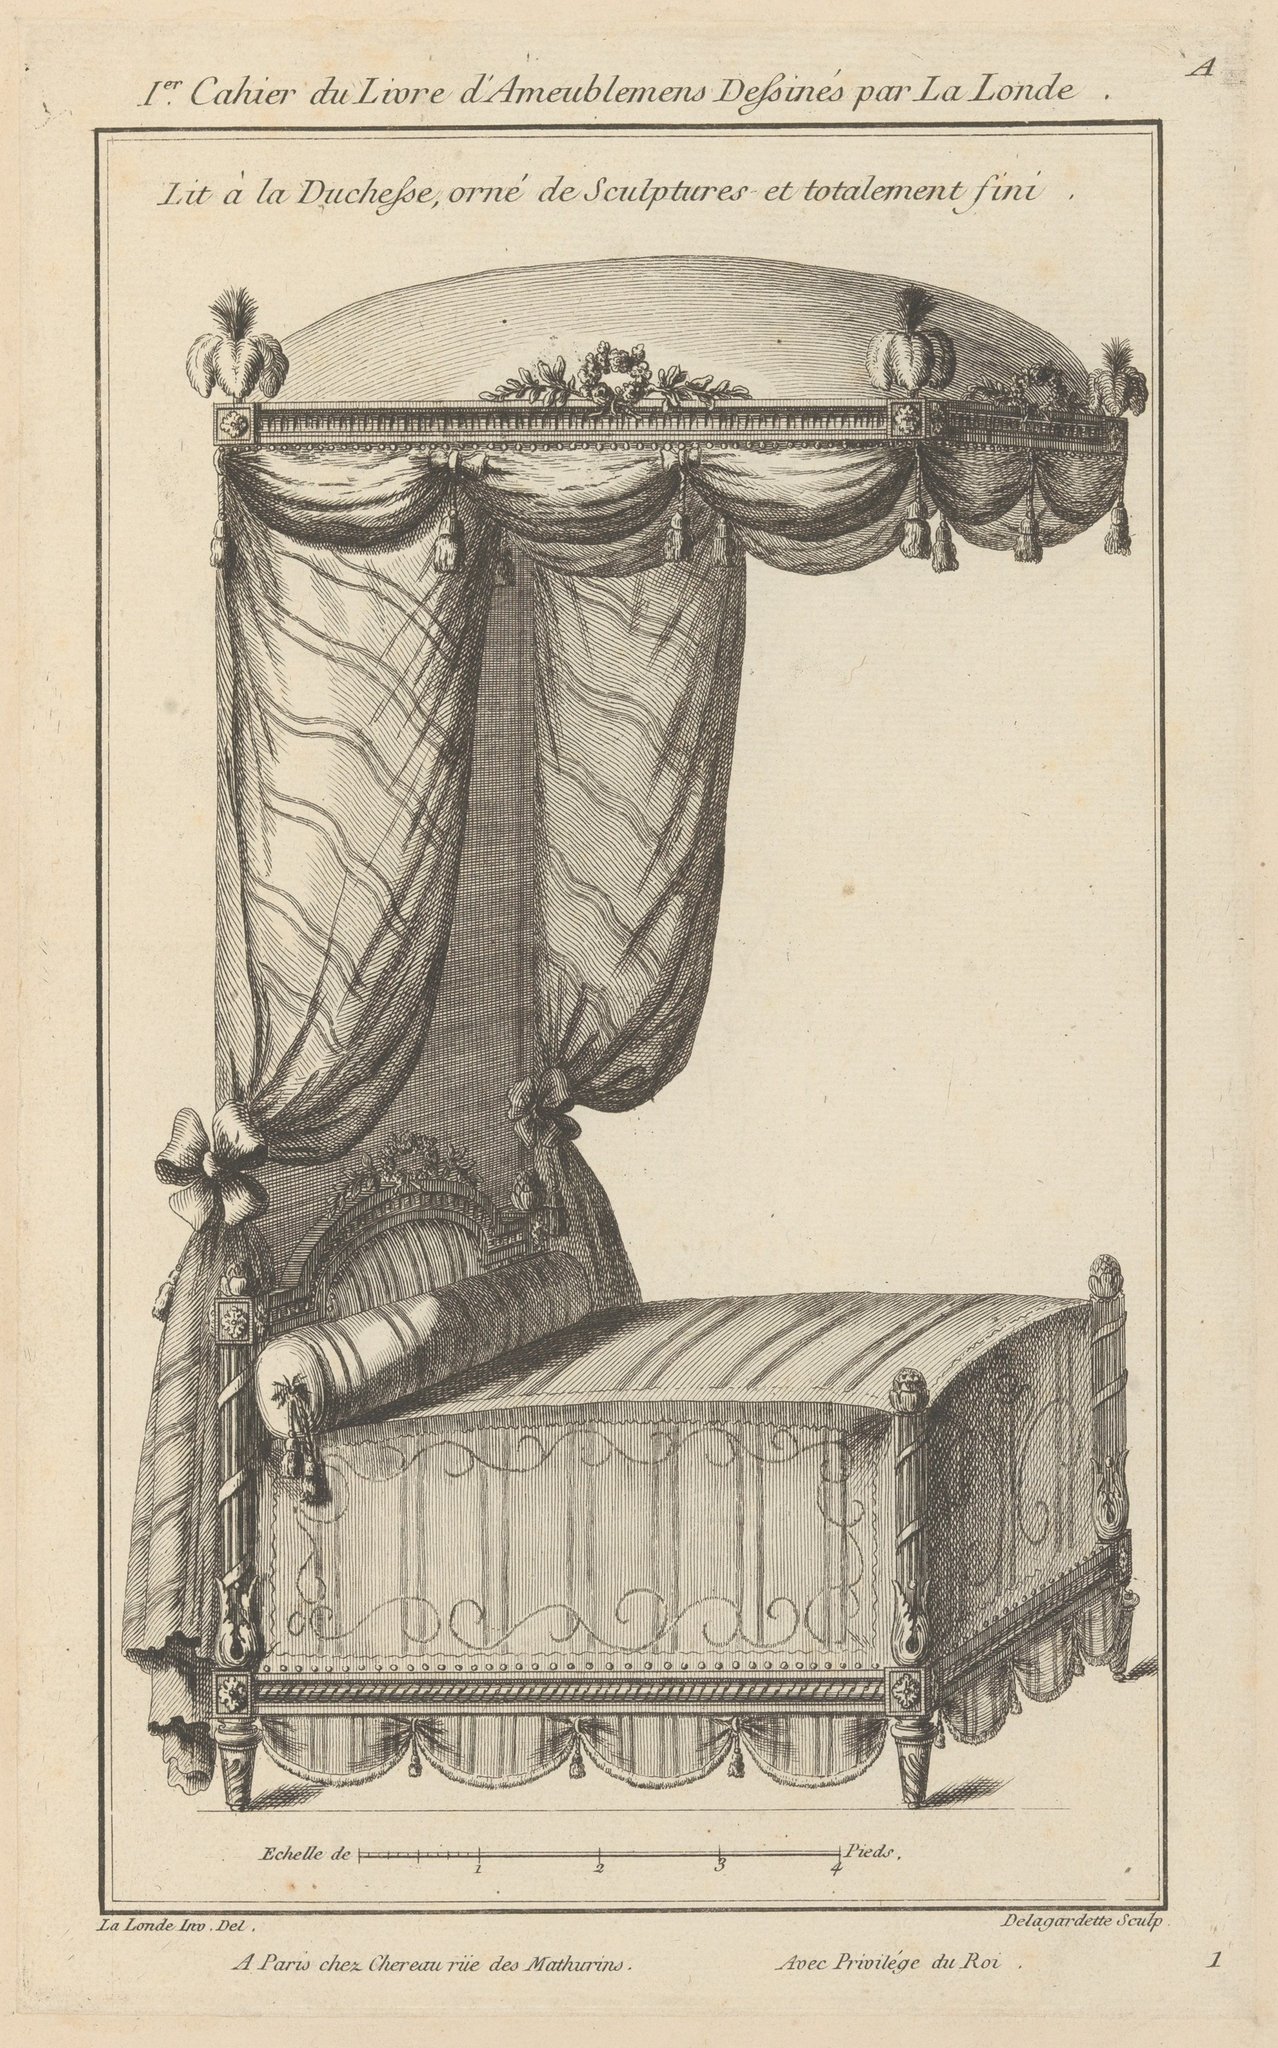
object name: book print ornament architecture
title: Oeuvres Diverses de Lalonde. Tome 2.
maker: richard de lalonde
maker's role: artist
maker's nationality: french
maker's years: 1780-1790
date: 1767-1800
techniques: engraving, etching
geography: france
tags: beds